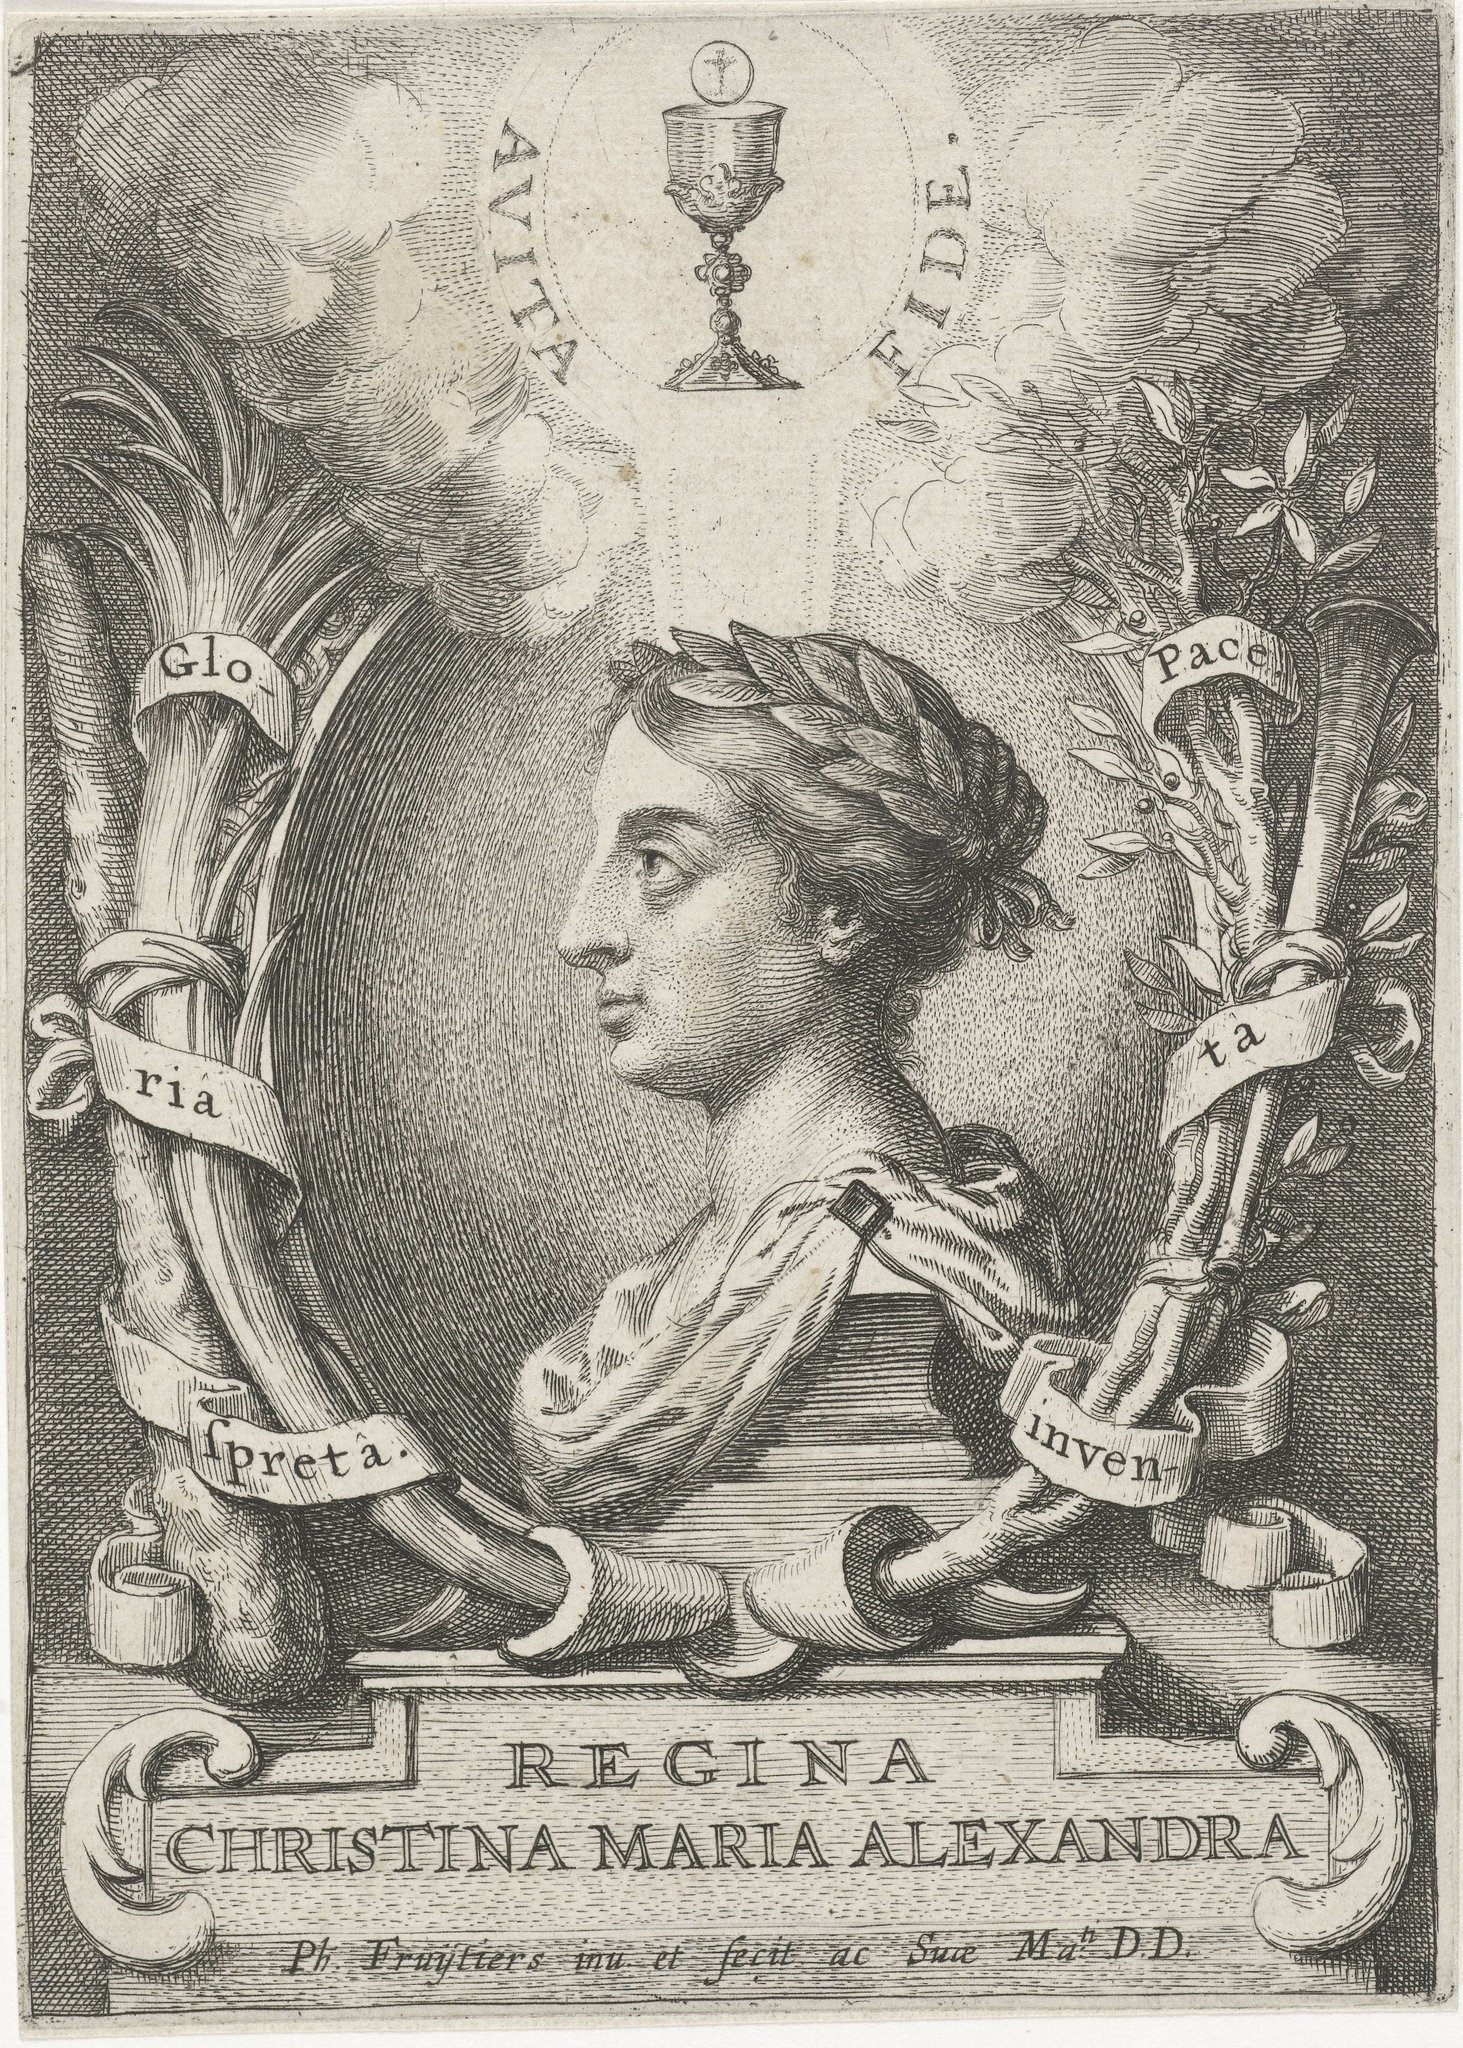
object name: print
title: Portrait of Christina of Sweden, Queen of Sweden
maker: philip fruytiers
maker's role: print maker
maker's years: 1610-1666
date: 1626-1666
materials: paper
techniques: etching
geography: antwerp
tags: rome, christina (koningin van zweden)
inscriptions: collector's mark: Lugt 2228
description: Portretbuste van Christina, koningin van Zweden, in profiel naar links. Haar hoofd is getooid met een lauwerkrans; hierboven is een hostiekelk in een lichtkrans weergegeven. Het borstbeeld is omlijst met palm- en olijftakken en wordt geflankeerd door een knots links en een bazuin rechts. De omlijsting is omwikkeld met een lint met de tekst: Gloria Spreta Inventa Pace. Onder de portetbuste staat op de sokkel de naam van de geportretteerde.